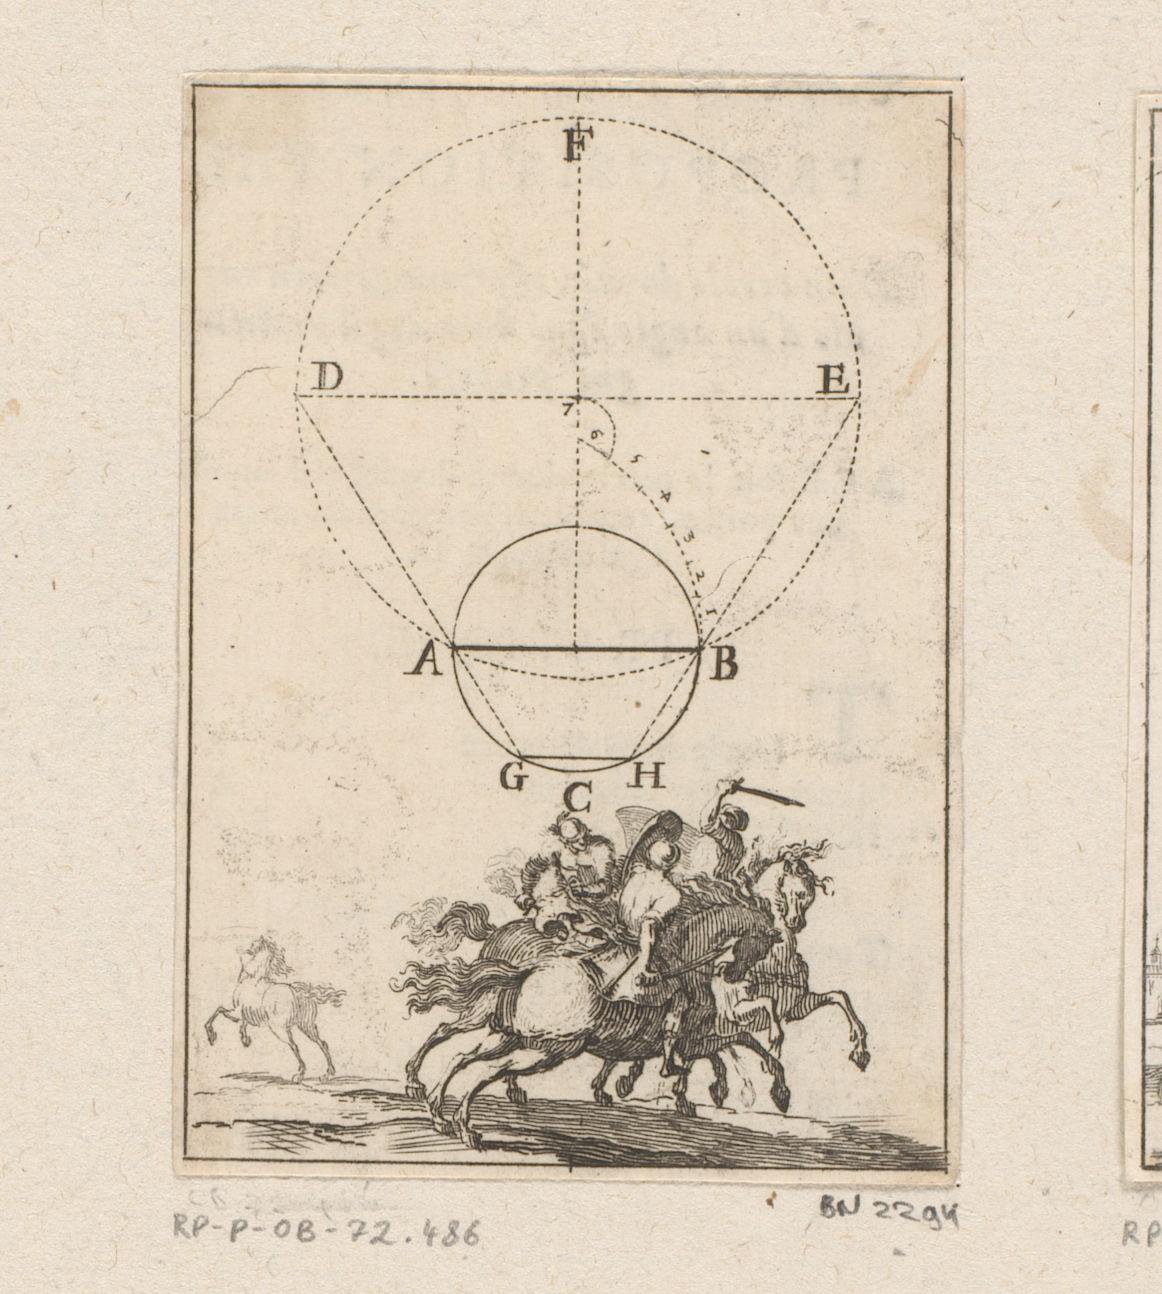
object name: book illustration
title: Veelhoek in een cirkel met onderaan ruiters te paard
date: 1669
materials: paper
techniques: etching, letterpress printing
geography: paris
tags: riding a horse, ass, or mule; rider, horseman, planimetry, geometry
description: Prent uit: Pratique de la géometrie, sur le papier et sur le terrain. Avec un nouvel ordre et une méthode particulière. Parijs: Thomas Jolly, 1669.